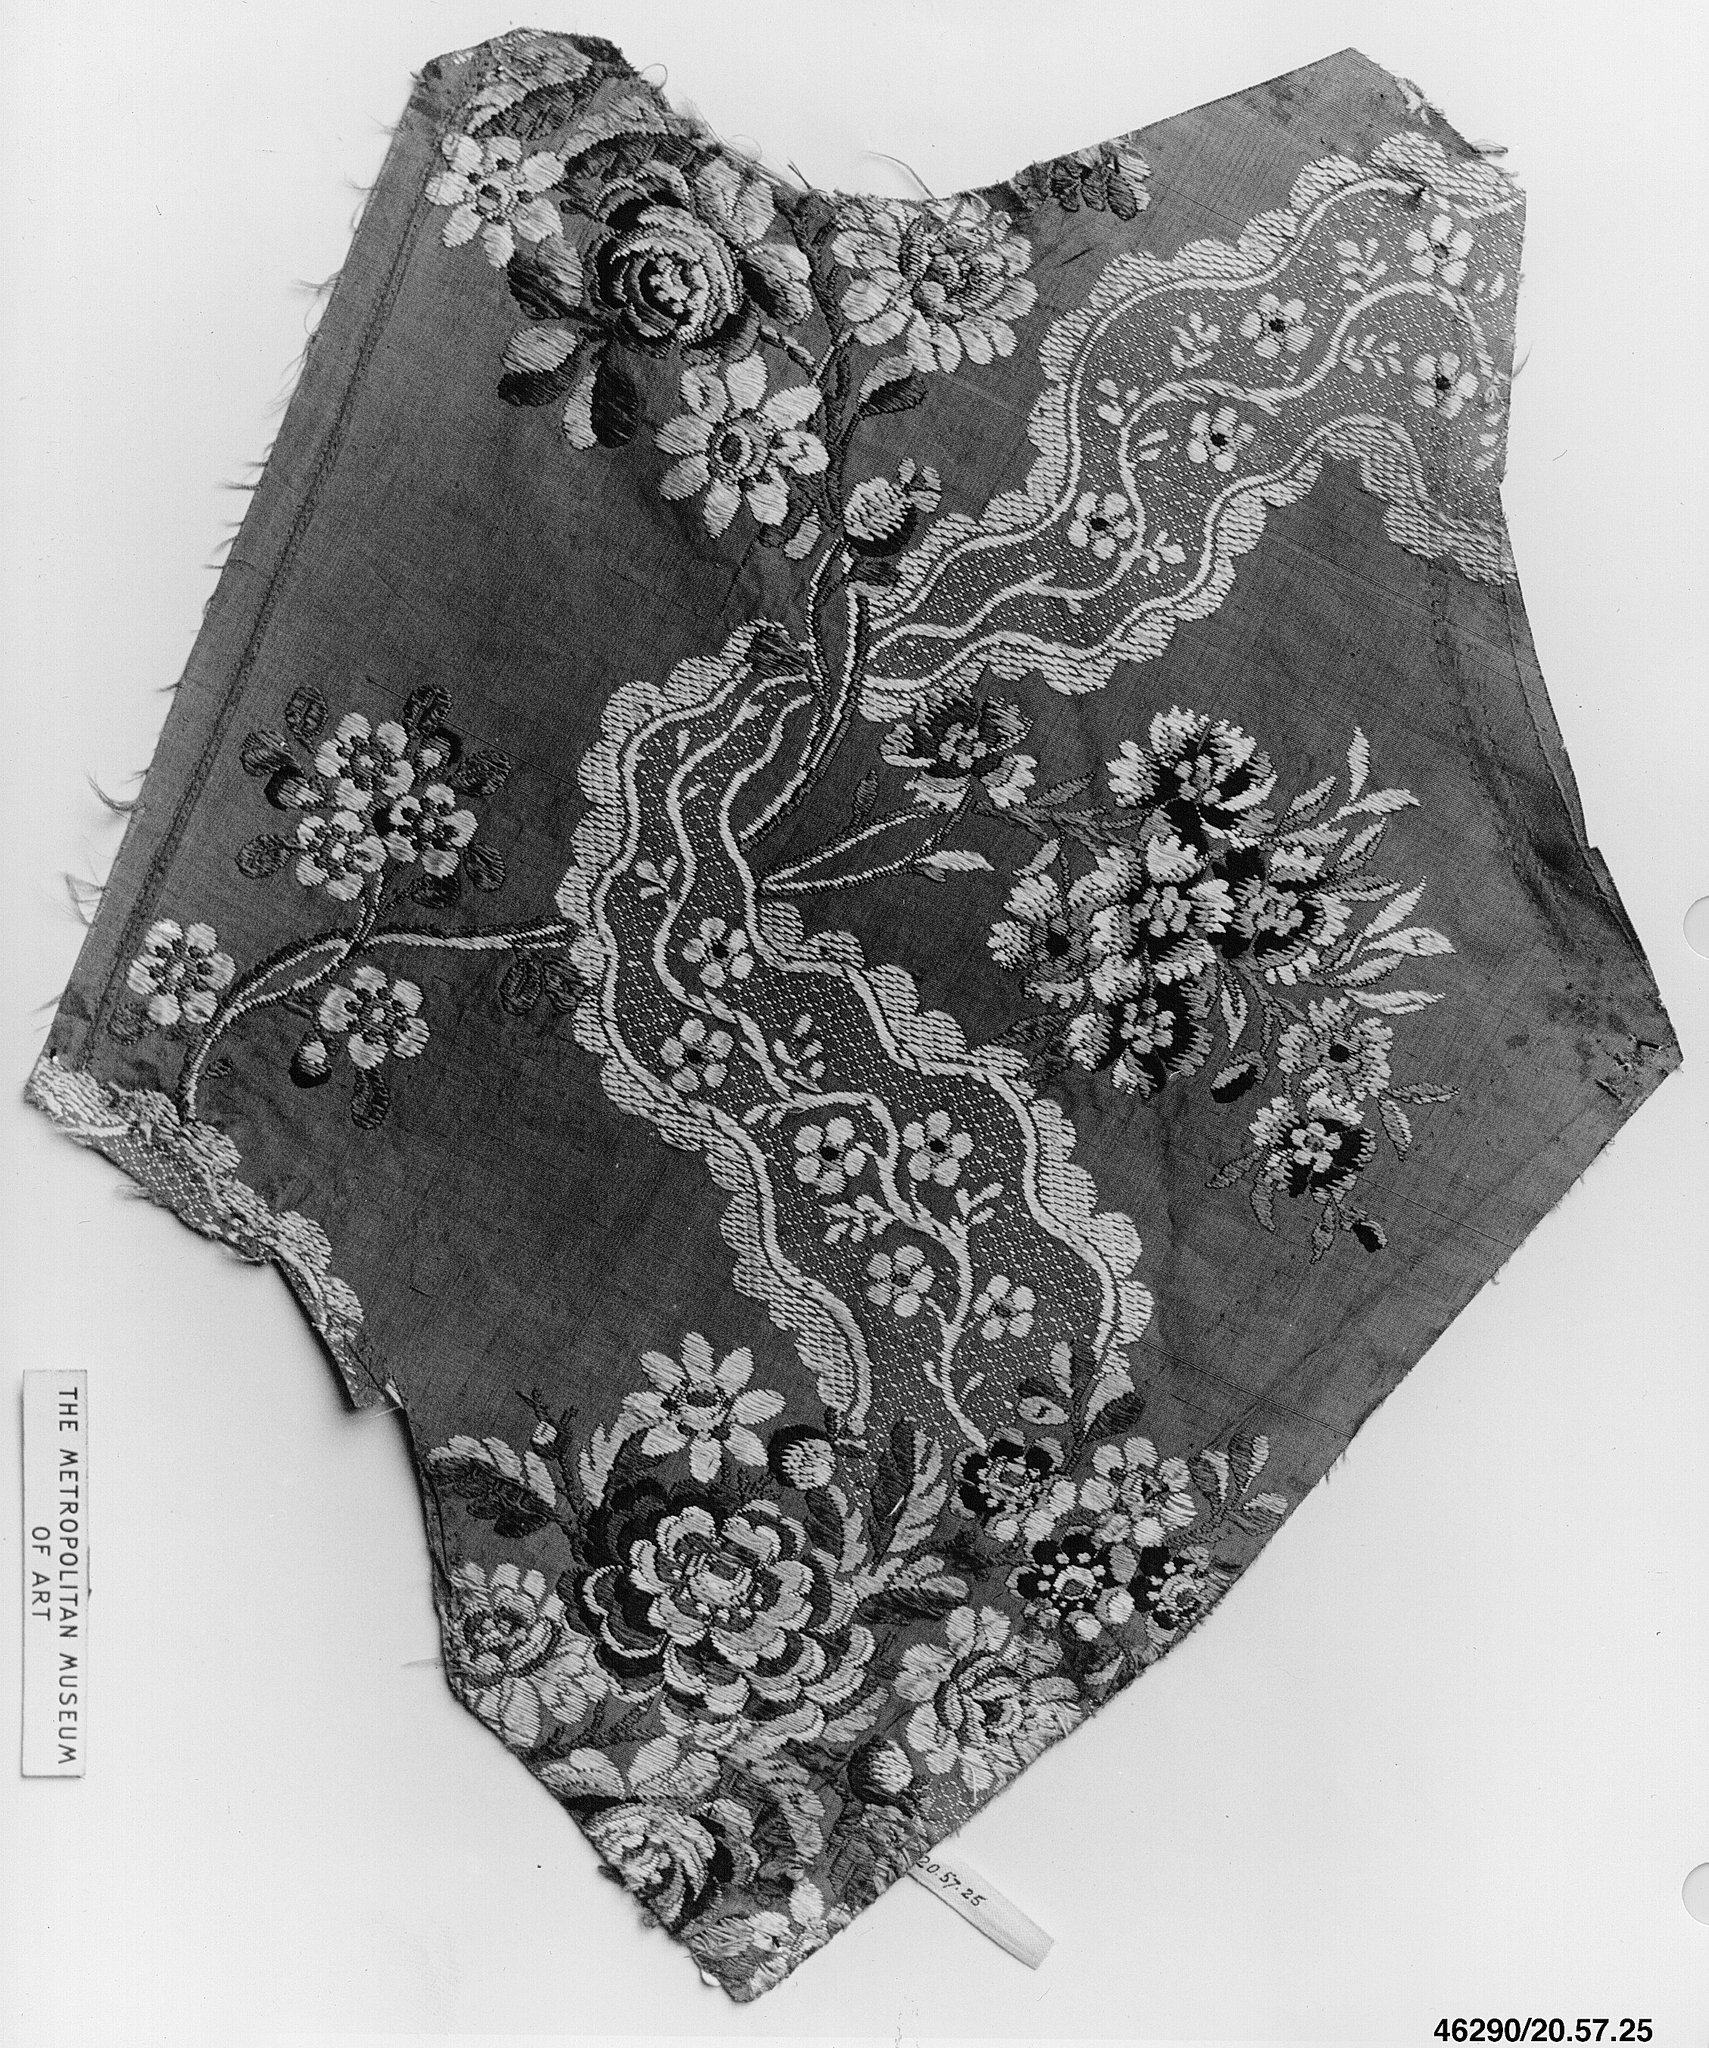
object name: piece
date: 1760-1765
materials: silk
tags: flowers,leaves